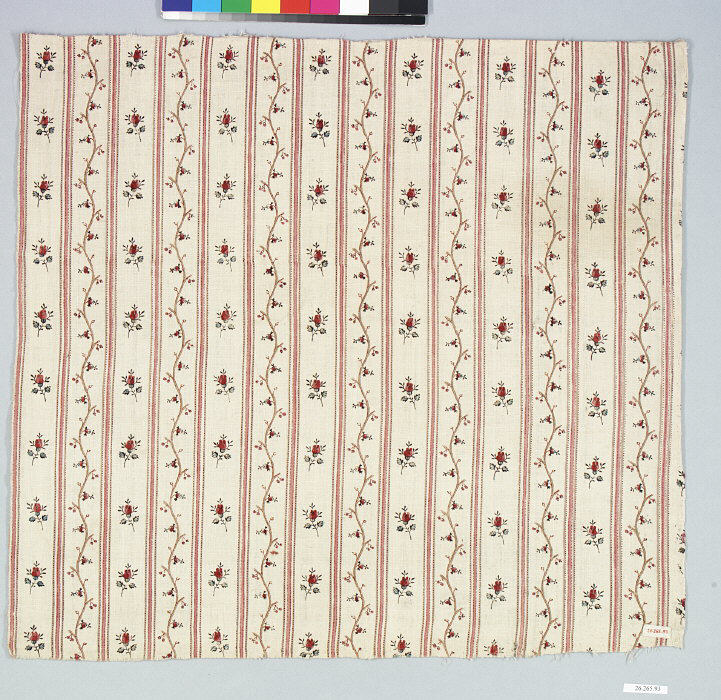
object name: piece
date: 1788-1790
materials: cotton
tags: flowers